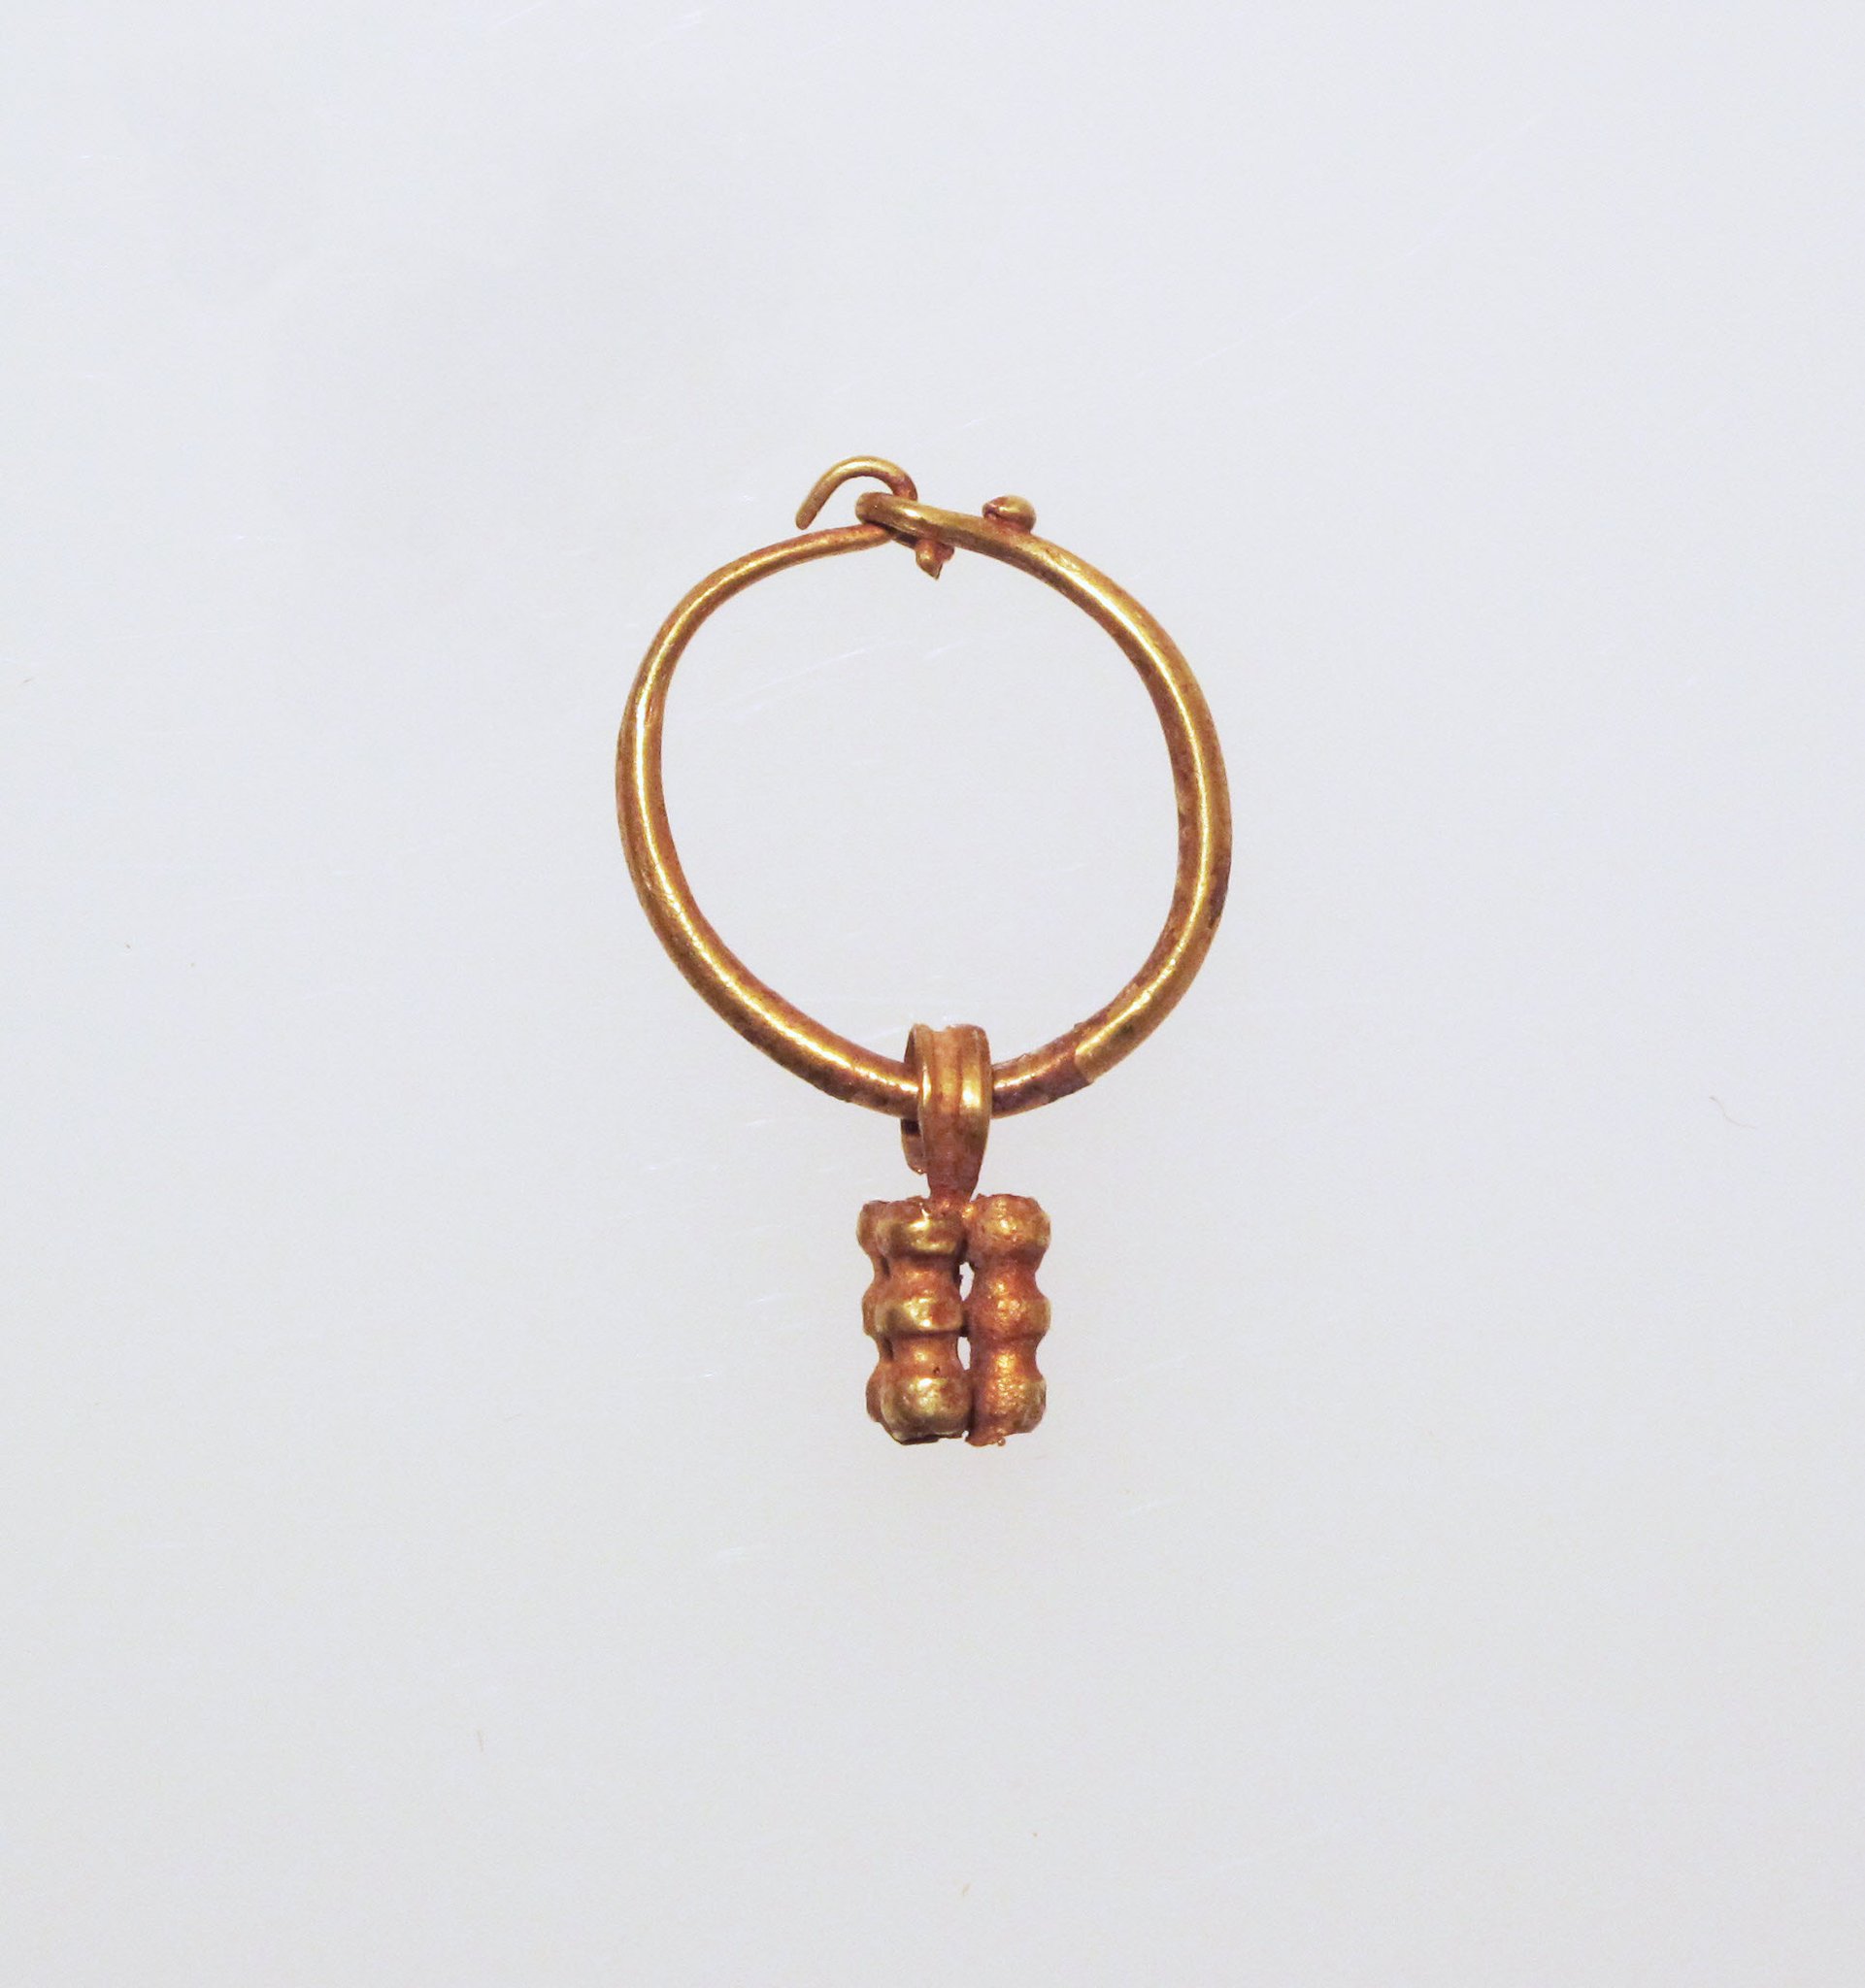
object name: earring with pendant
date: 7000 BCE-330 CE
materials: gold